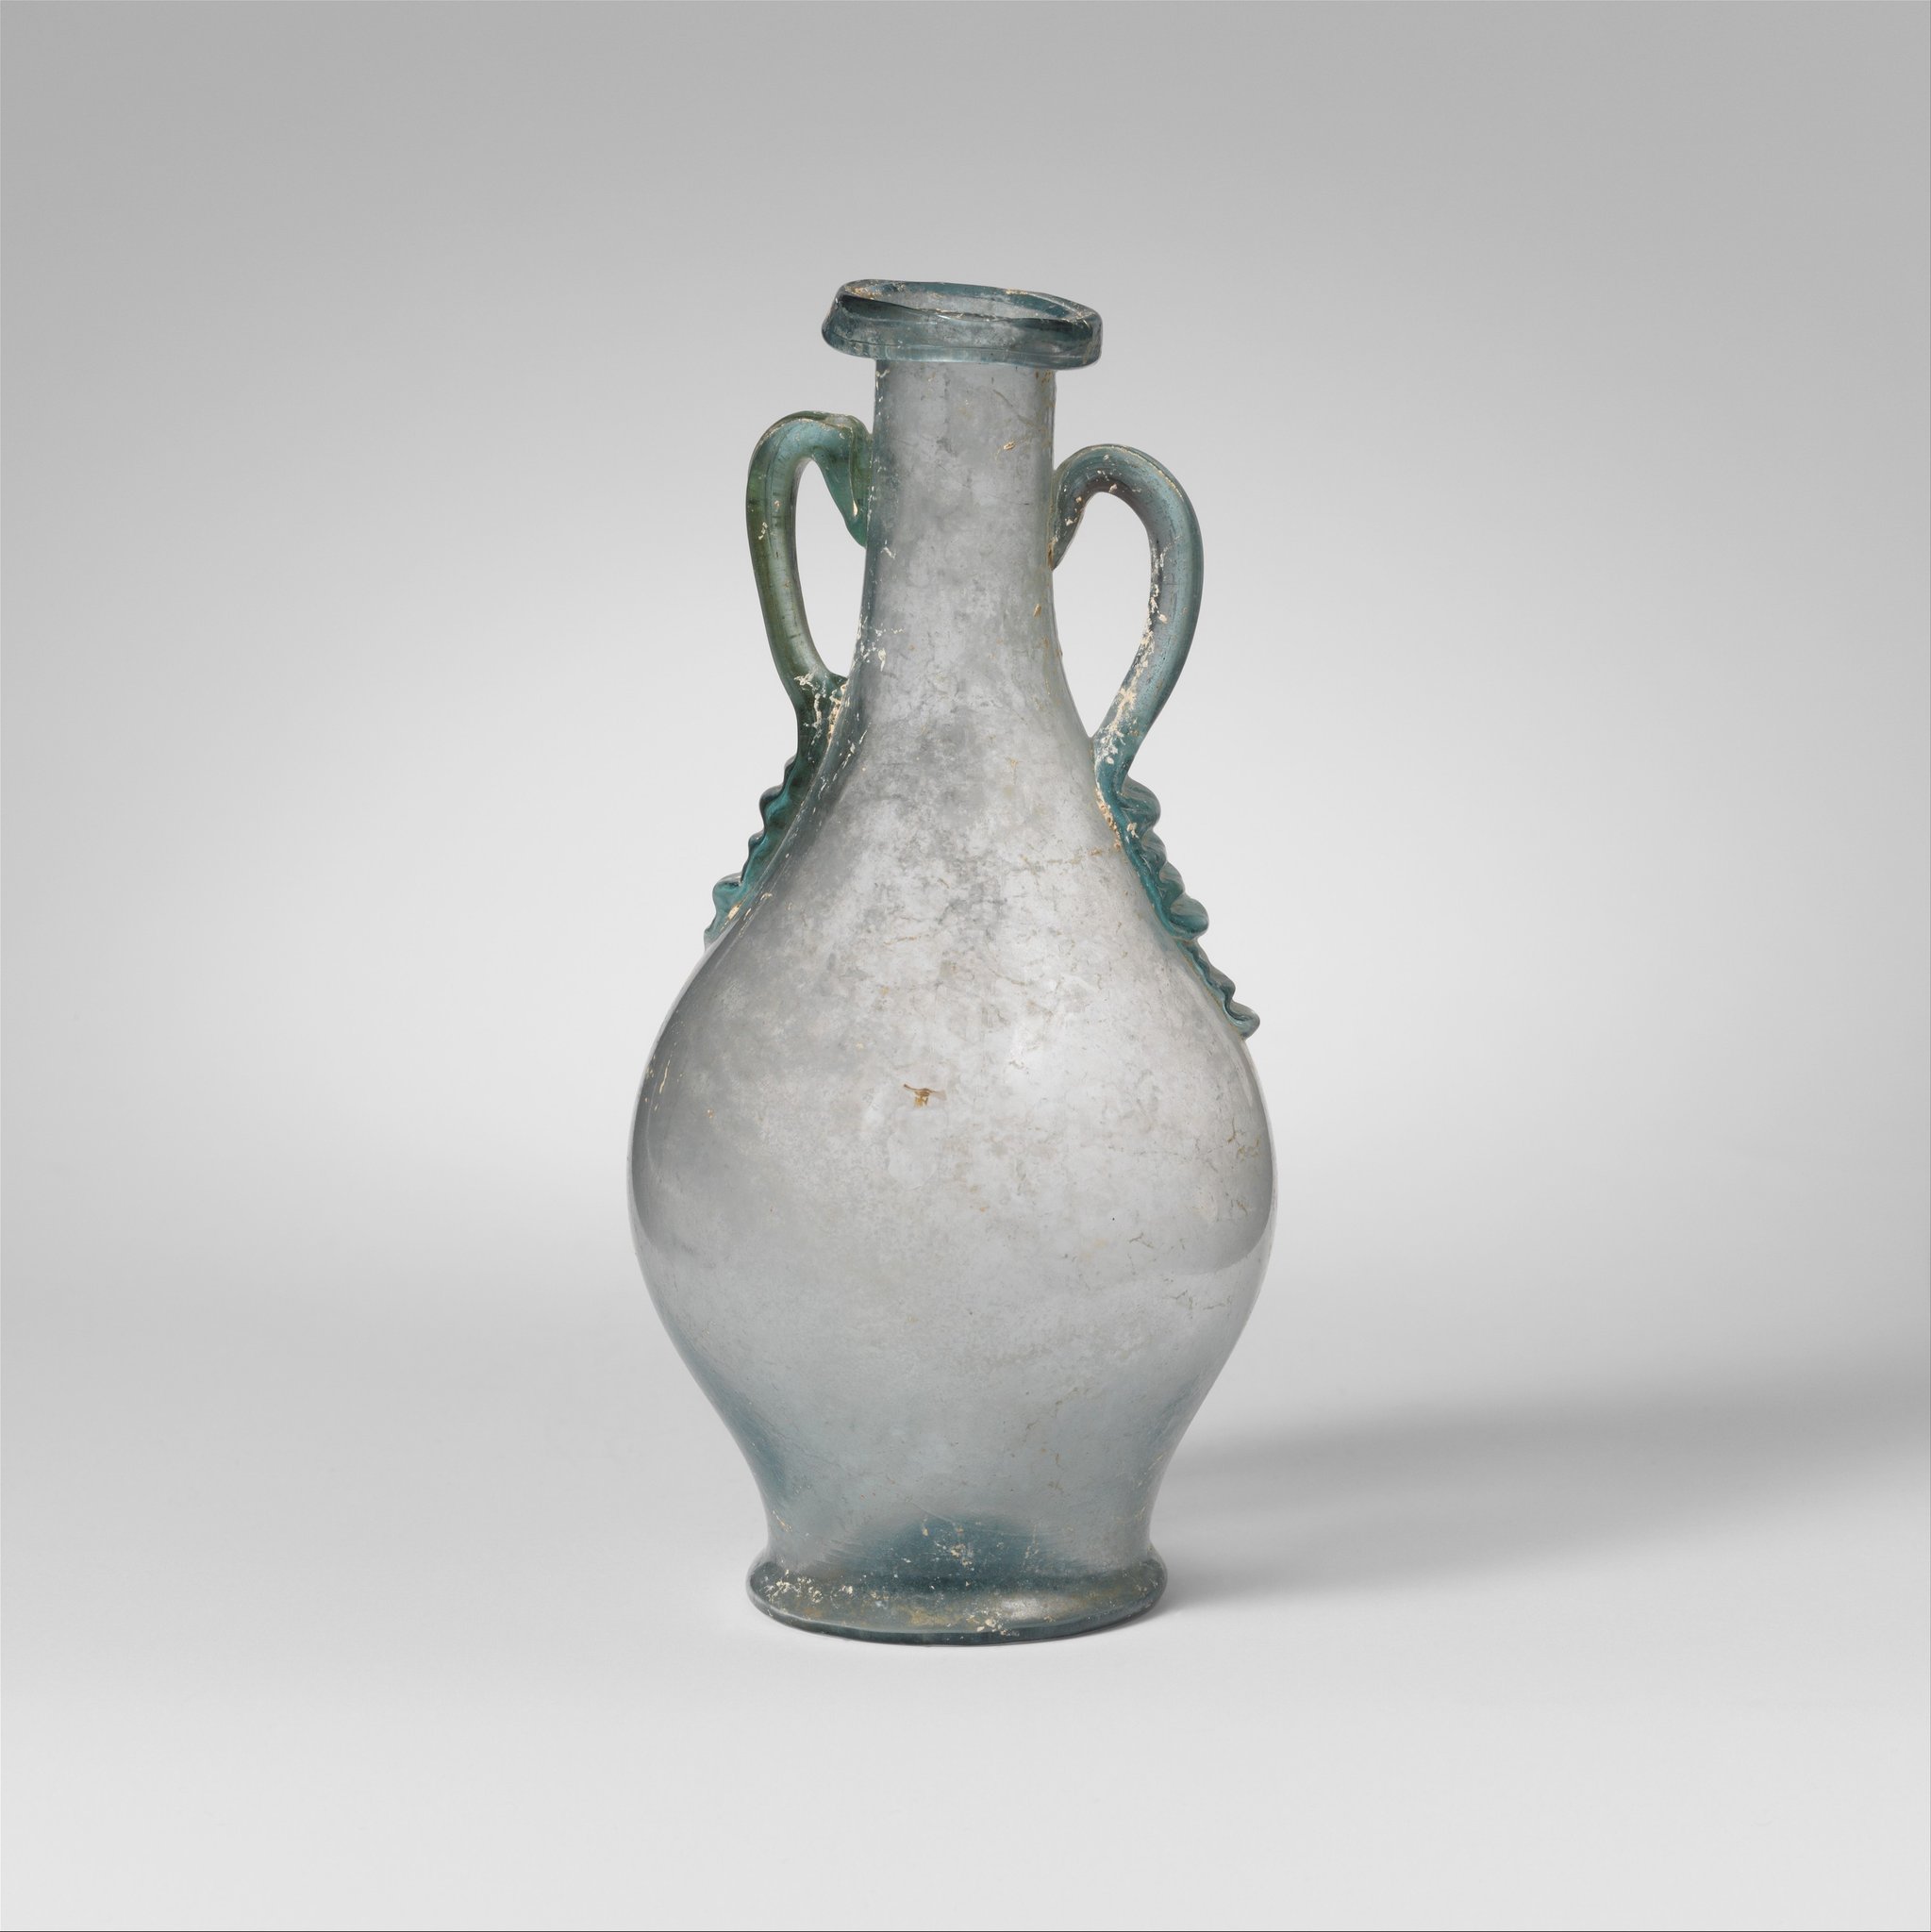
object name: amphora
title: Glass two-handled bottle (amphora)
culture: roman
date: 1-200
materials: glass